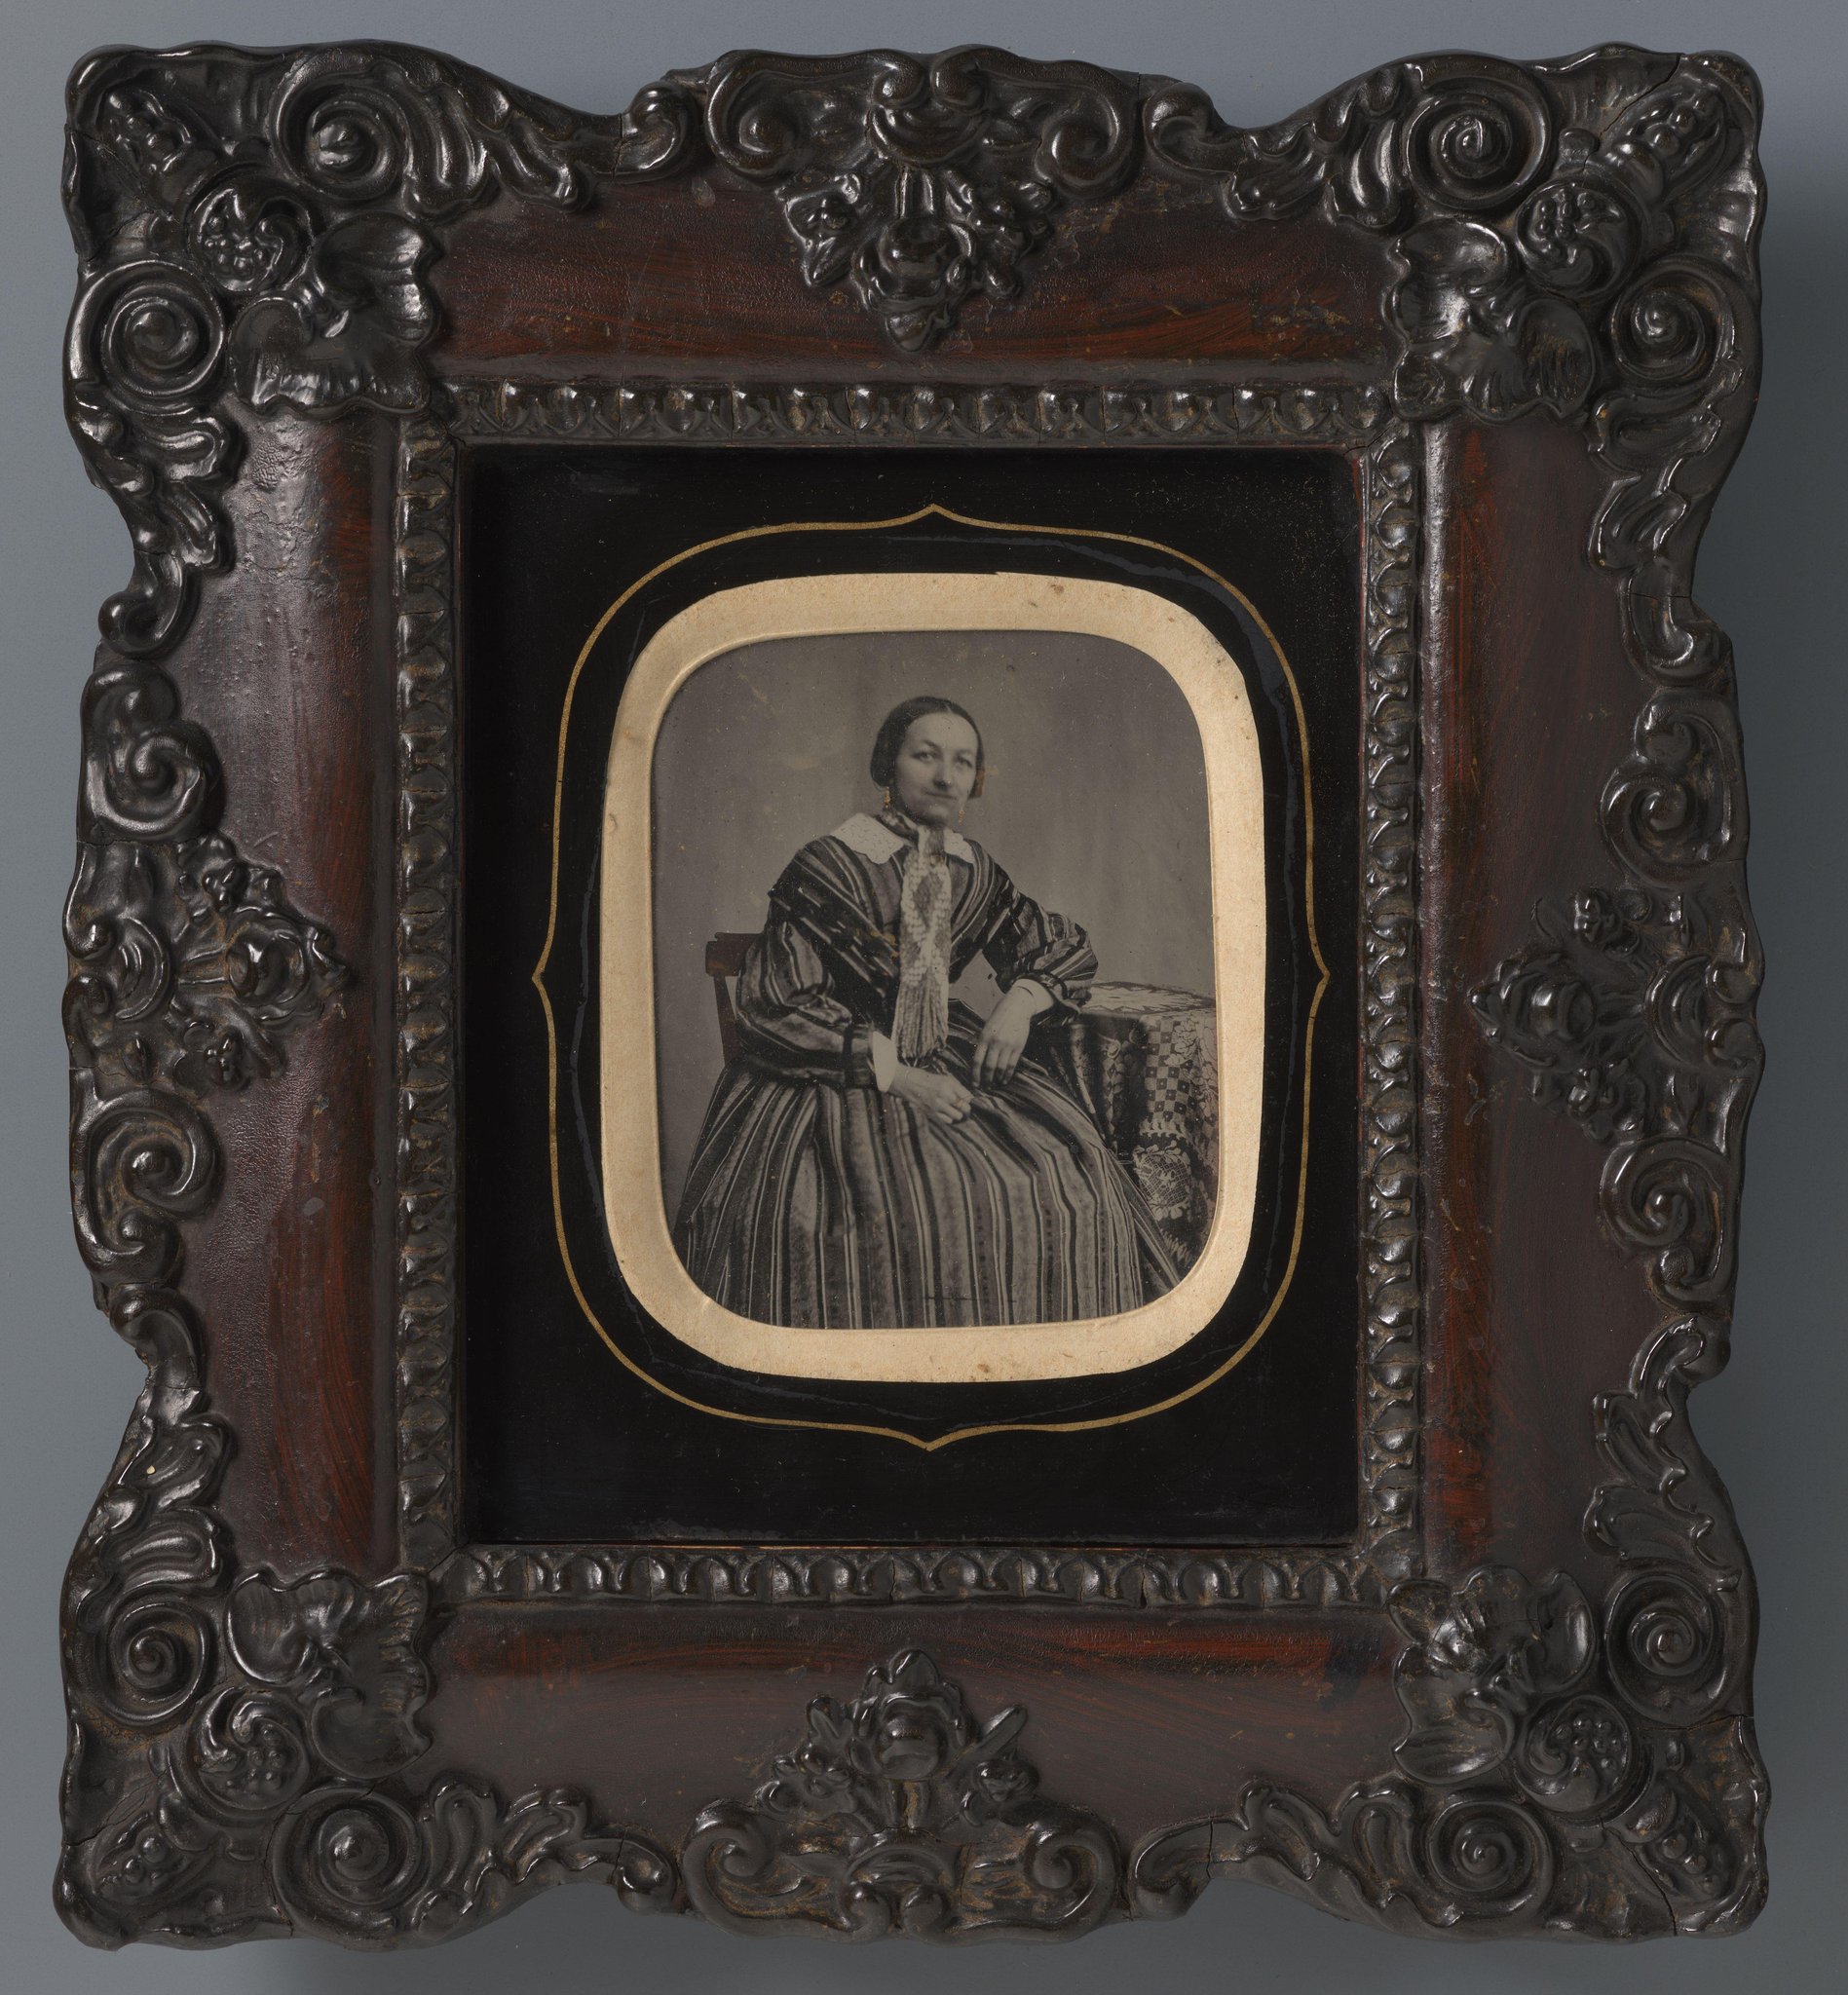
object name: frame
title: Portret van een onbekende vrouw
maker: johan godfried blankenburg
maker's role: fotograaf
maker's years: 1819-1892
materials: cardboard, glass, wood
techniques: ambrotype, hand coloring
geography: amsterdam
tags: historical persons - bb - woman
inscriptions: inscription: ‘[J.] G. BLANKENBURG/ [...]EINSCHILDER & PHOTOGRAPHISCT./ Recommandeert/ zich tot het vervaardigen van/ Photographien & Daguerreotypien/ welke dagelijks vervaardigd worden/ van 's morgens 9 tot 's middags [.] uren./ Kalverstraat D 33,/ [...]sschen de St. Joris & Olieslagersstegen/ Amsterdam’